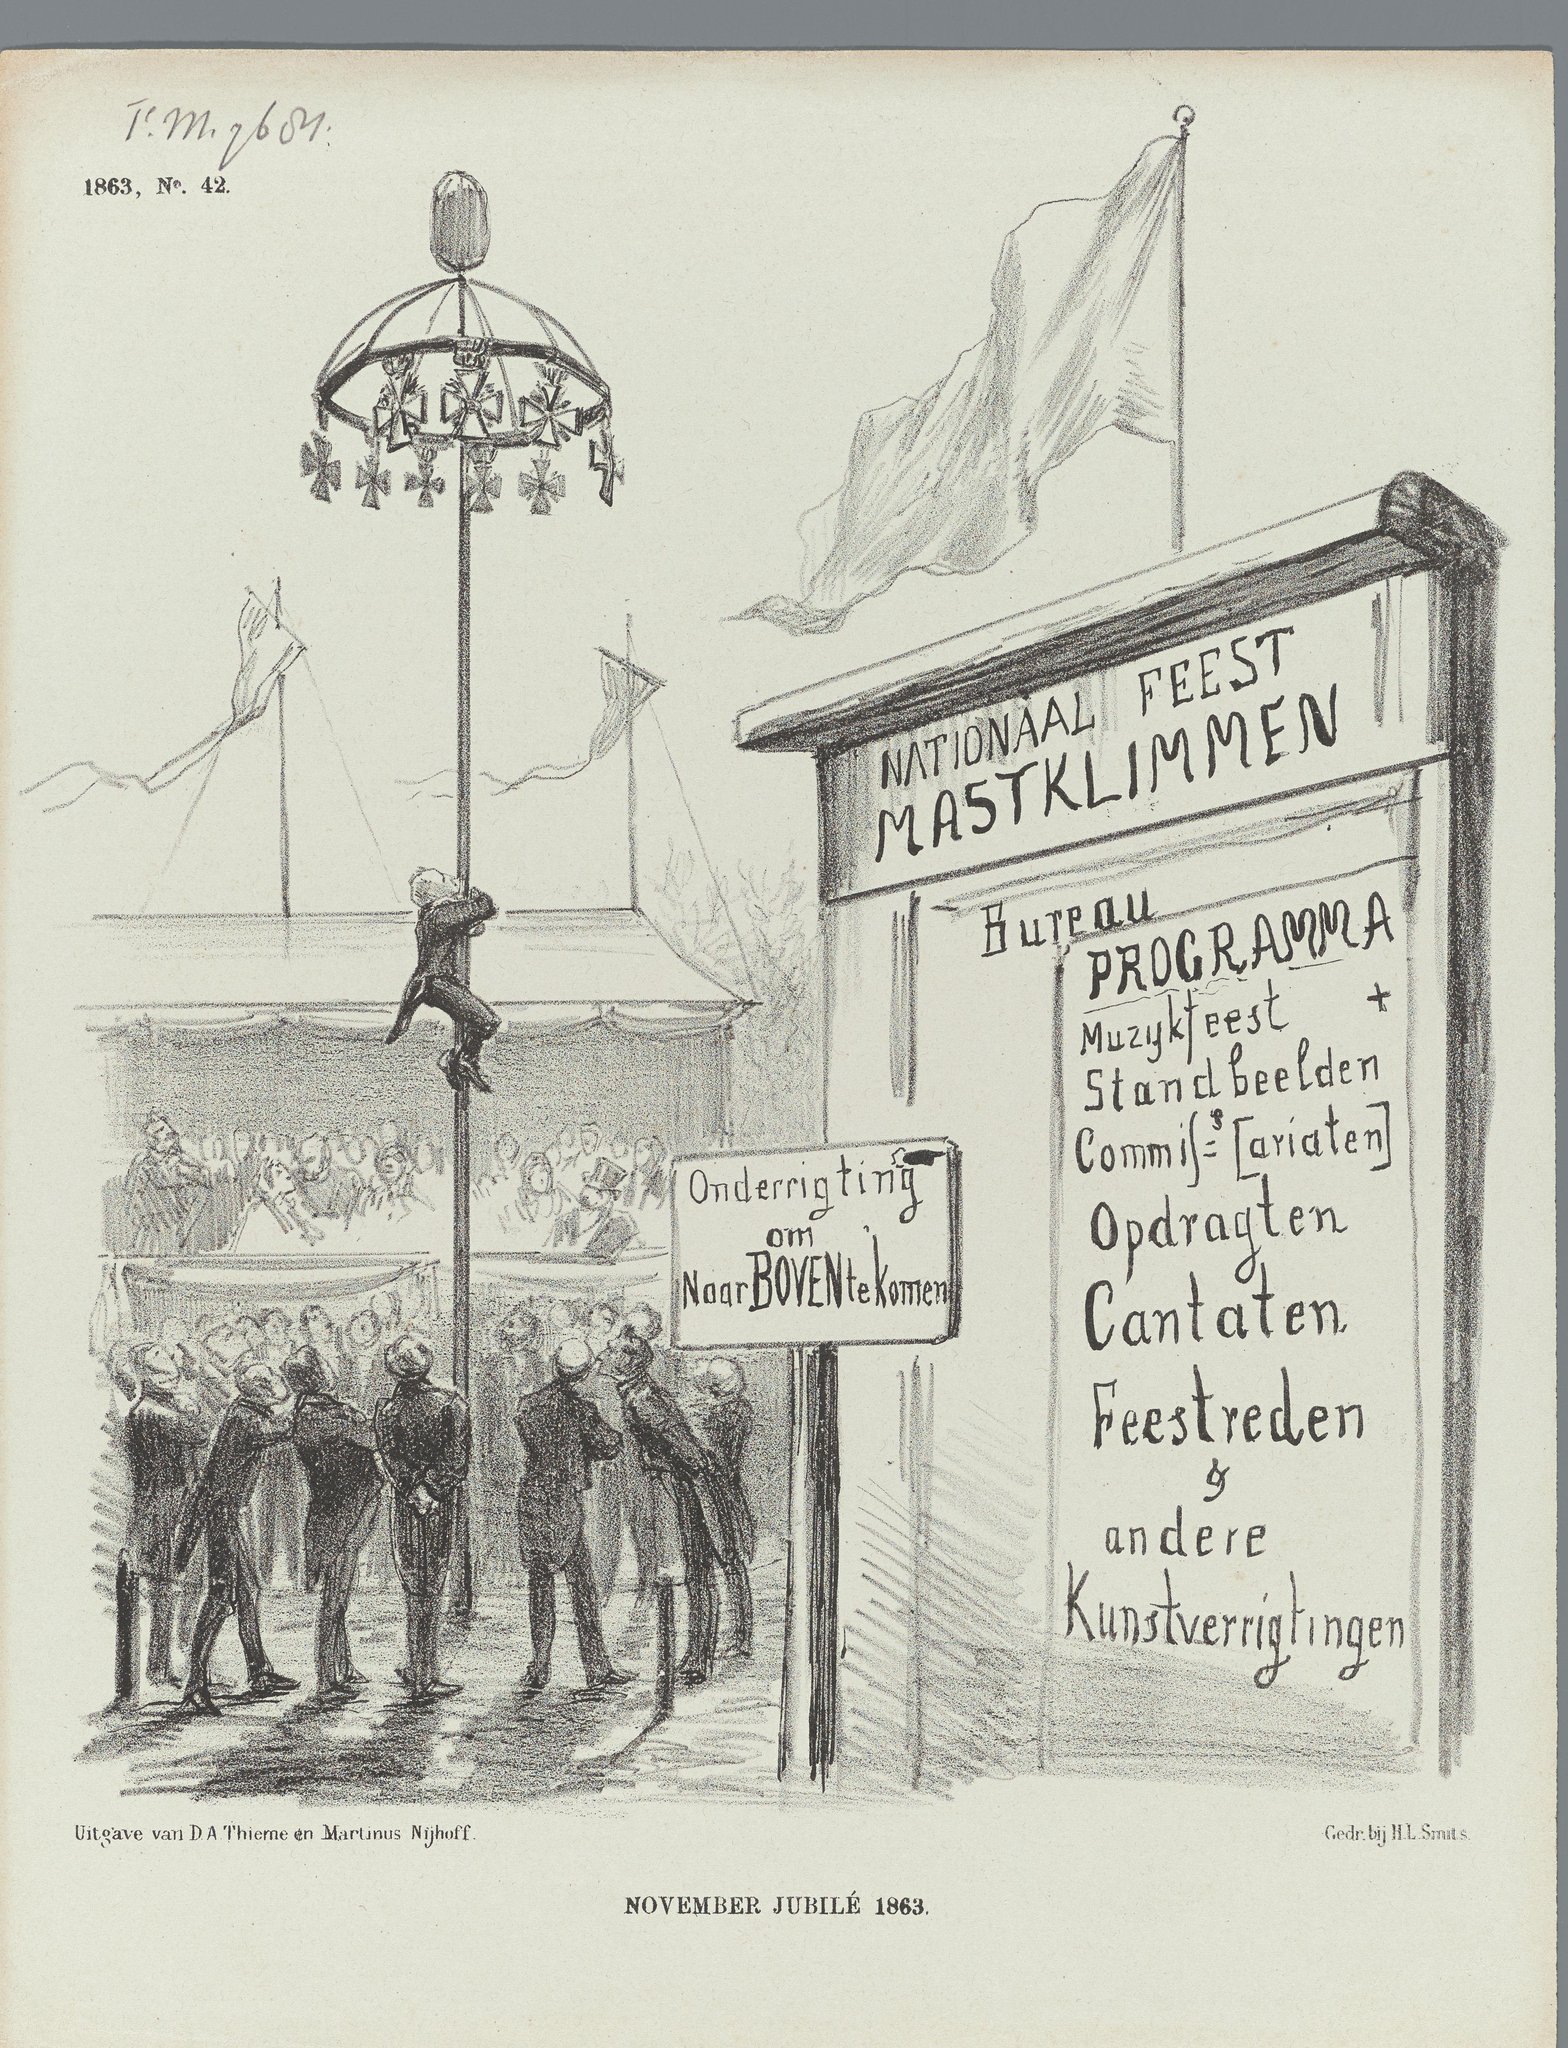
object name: cartoon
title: Spotprent op de hoop op een ridderorde bij de novemberfeesten, 1863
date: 1863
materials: paper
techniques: lithograph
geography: netherlands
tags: pleasure fair and circus, decorations, honours (as symbols of the state, etc.)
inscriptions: collector's mark: Lugt 2228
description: Spotprent op de hoop op een ridderorde bij de novemberfeesten. Een man probeert op een kermis in een mast te klimmen in de top waarvan de onderscheidingen hangen. Plaat verschenen bij het weekblad De Nederlandsche Spectator, nr. 42, 17 oktober 1863.